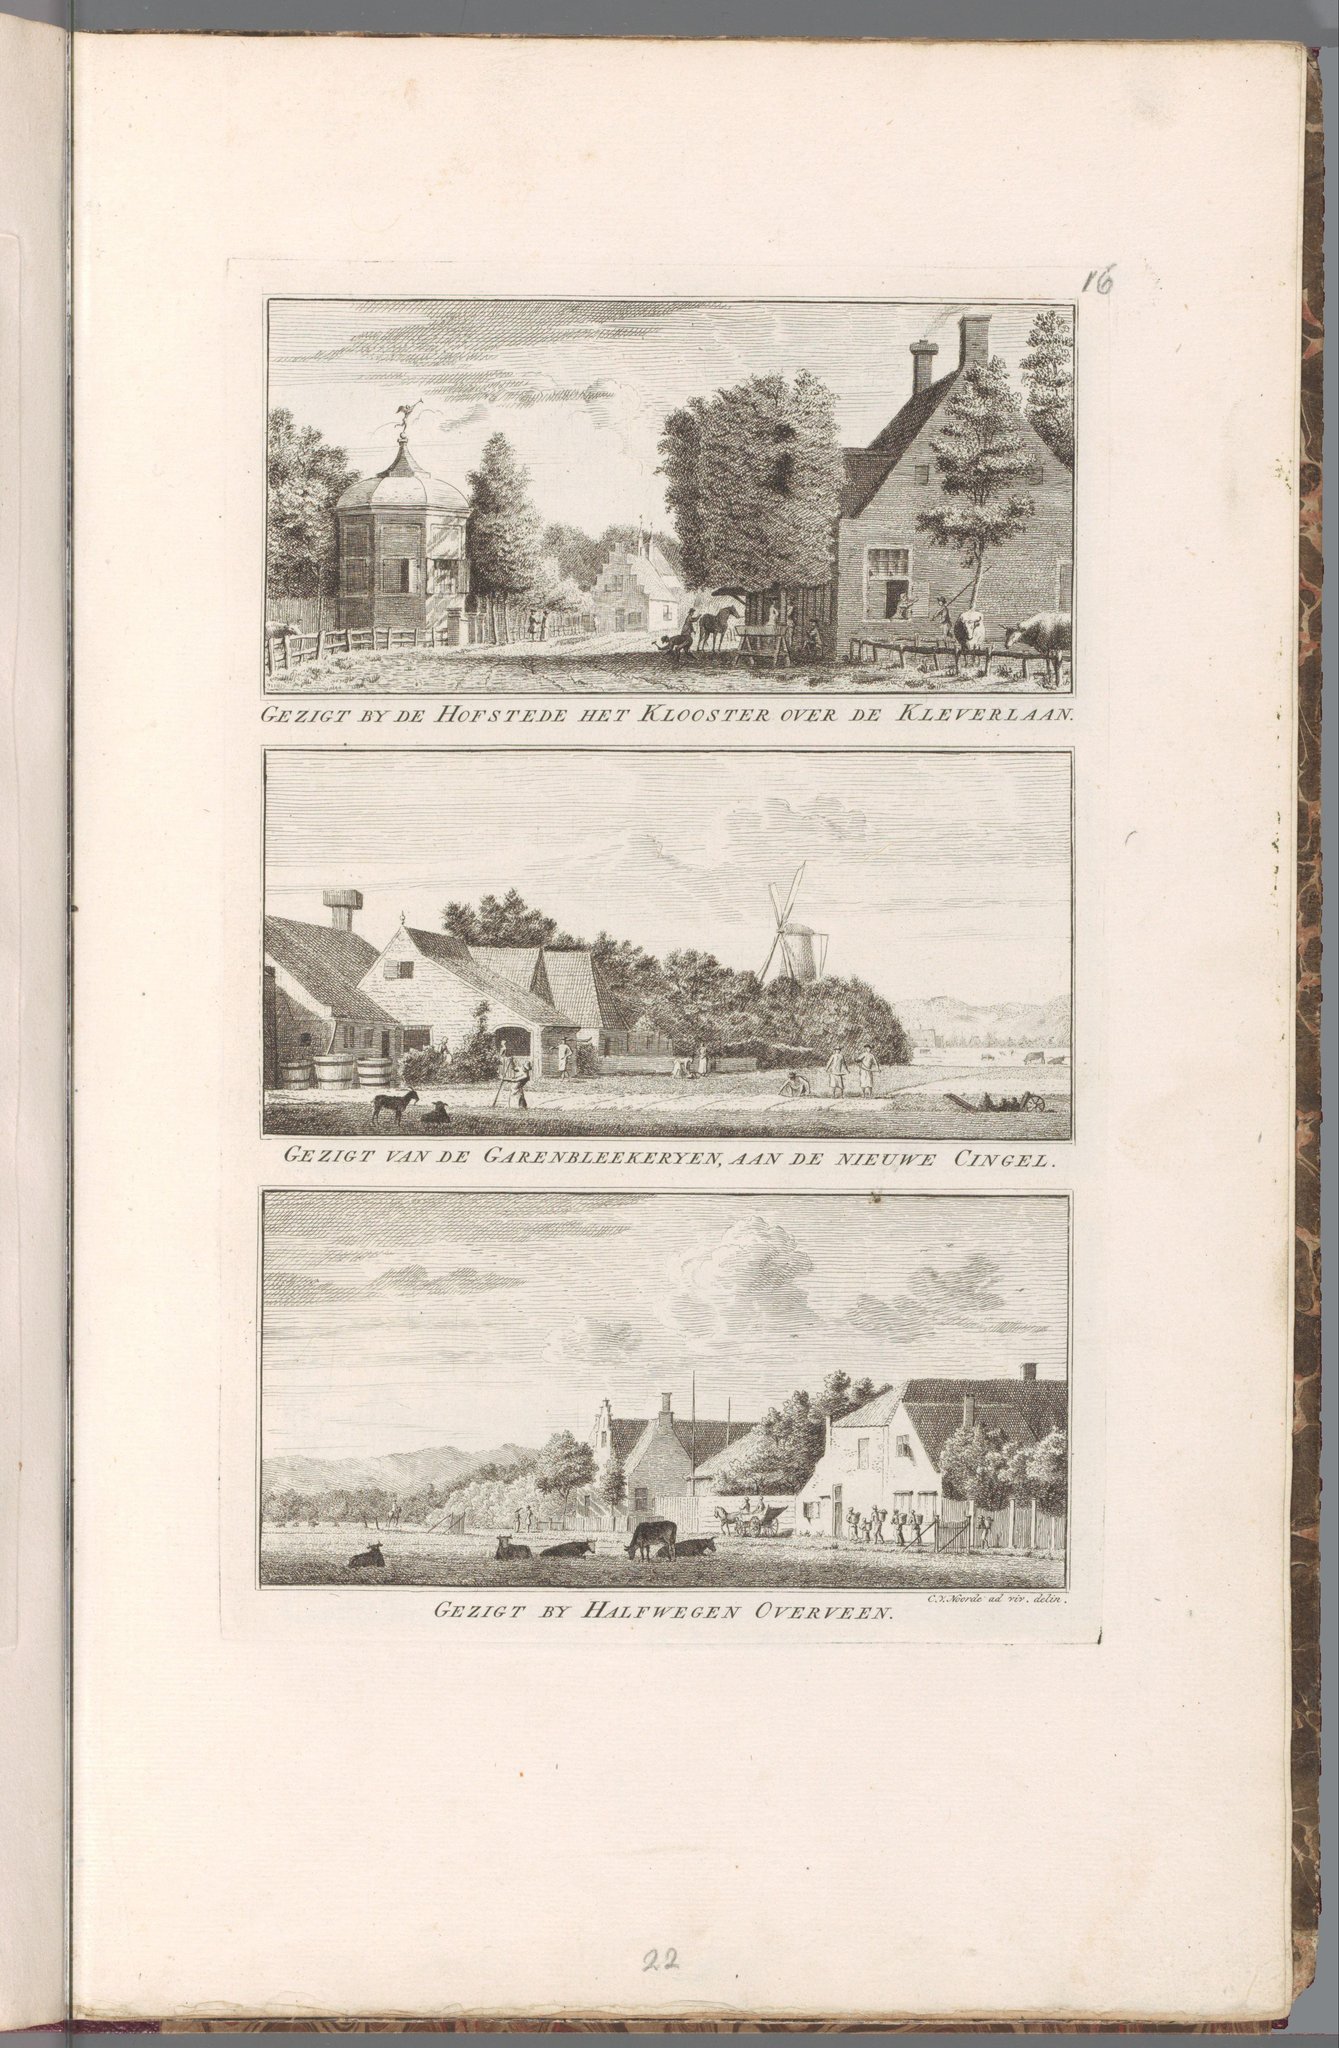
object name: album leaf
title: Gezigt by de Hofstede het Klooster over de Kleverlaan / Gezigt van de Garenbleekeryen, aan de Nieuwe Cingel / Gezigt by Halfwegen Overveen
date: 1762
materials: paper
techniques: etching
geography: haarlem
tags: river, canal, lane, alley, haarlem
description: Drie voorstellingen. Boven: De Kleverlaan te Haarlem bij Hofstede Het Klooster. Midden: Garenblekerijen aan de singel bij de Zijlpoort te Haarlem. Onder: Enkele huizen tussen Haarlem en Overveen bij de huidige Julianalaan te Haarlem. Deze prent maakt deel uit van een album.